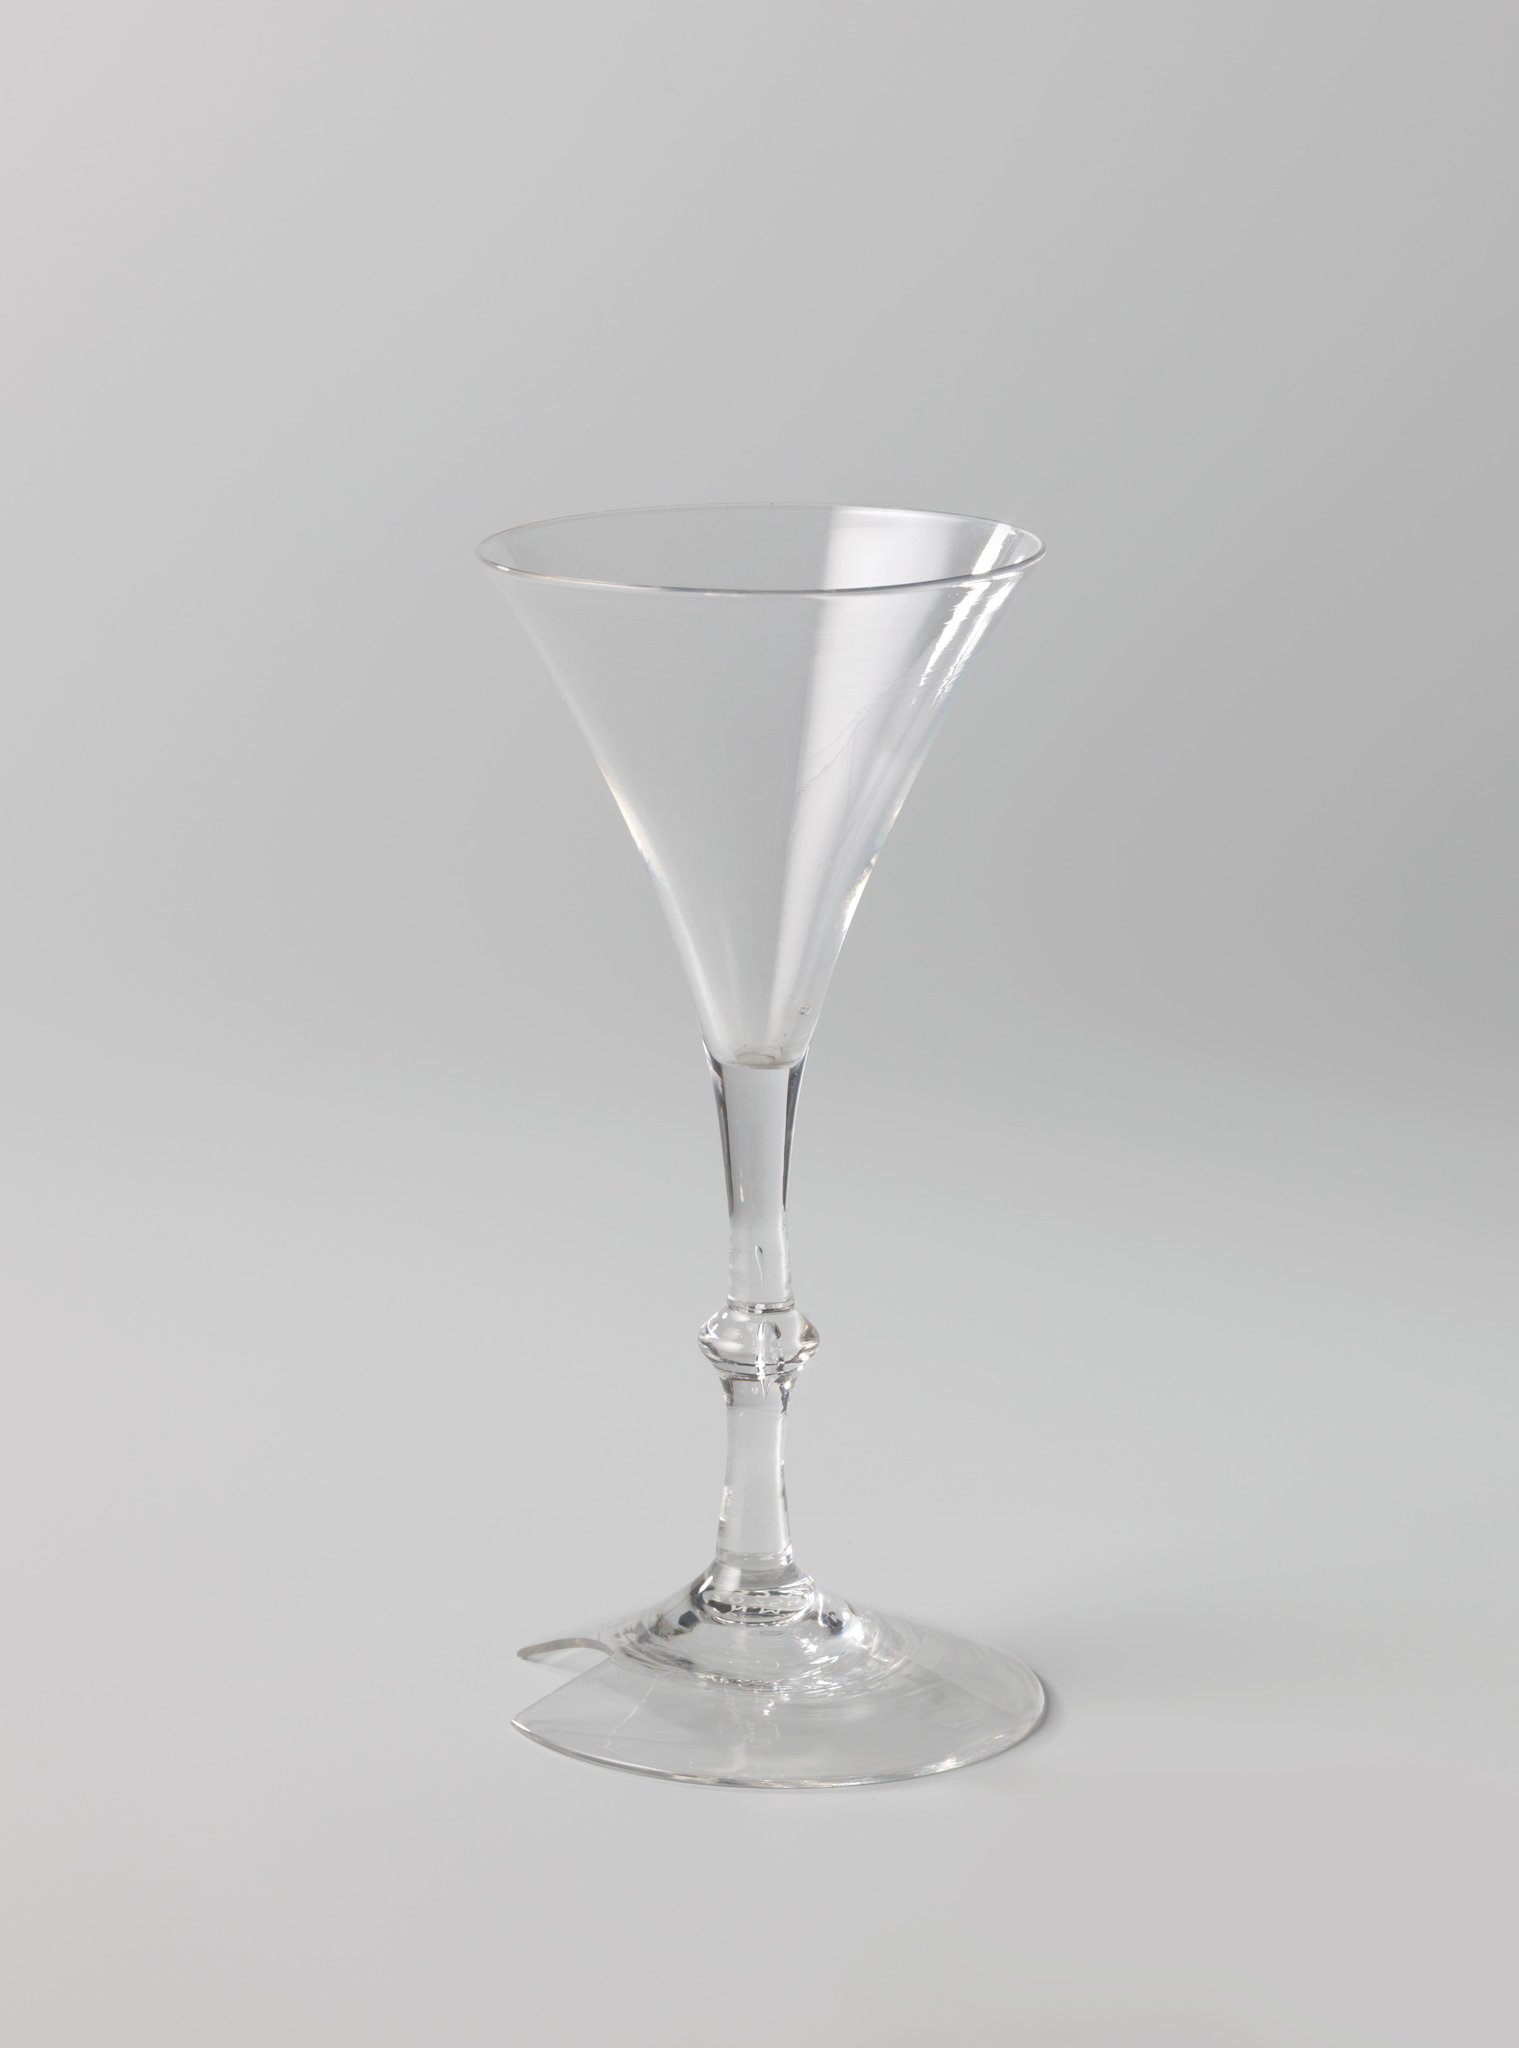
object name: goblet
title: Kelkglas met trompetvormige kelk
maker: Anonymous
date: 1750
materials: glass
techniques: glassblowing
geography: england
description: Kelkglas op conische voet. Balustroïde stam met ingestoken luchtbel, overgaande in een trompetvormige kelk.